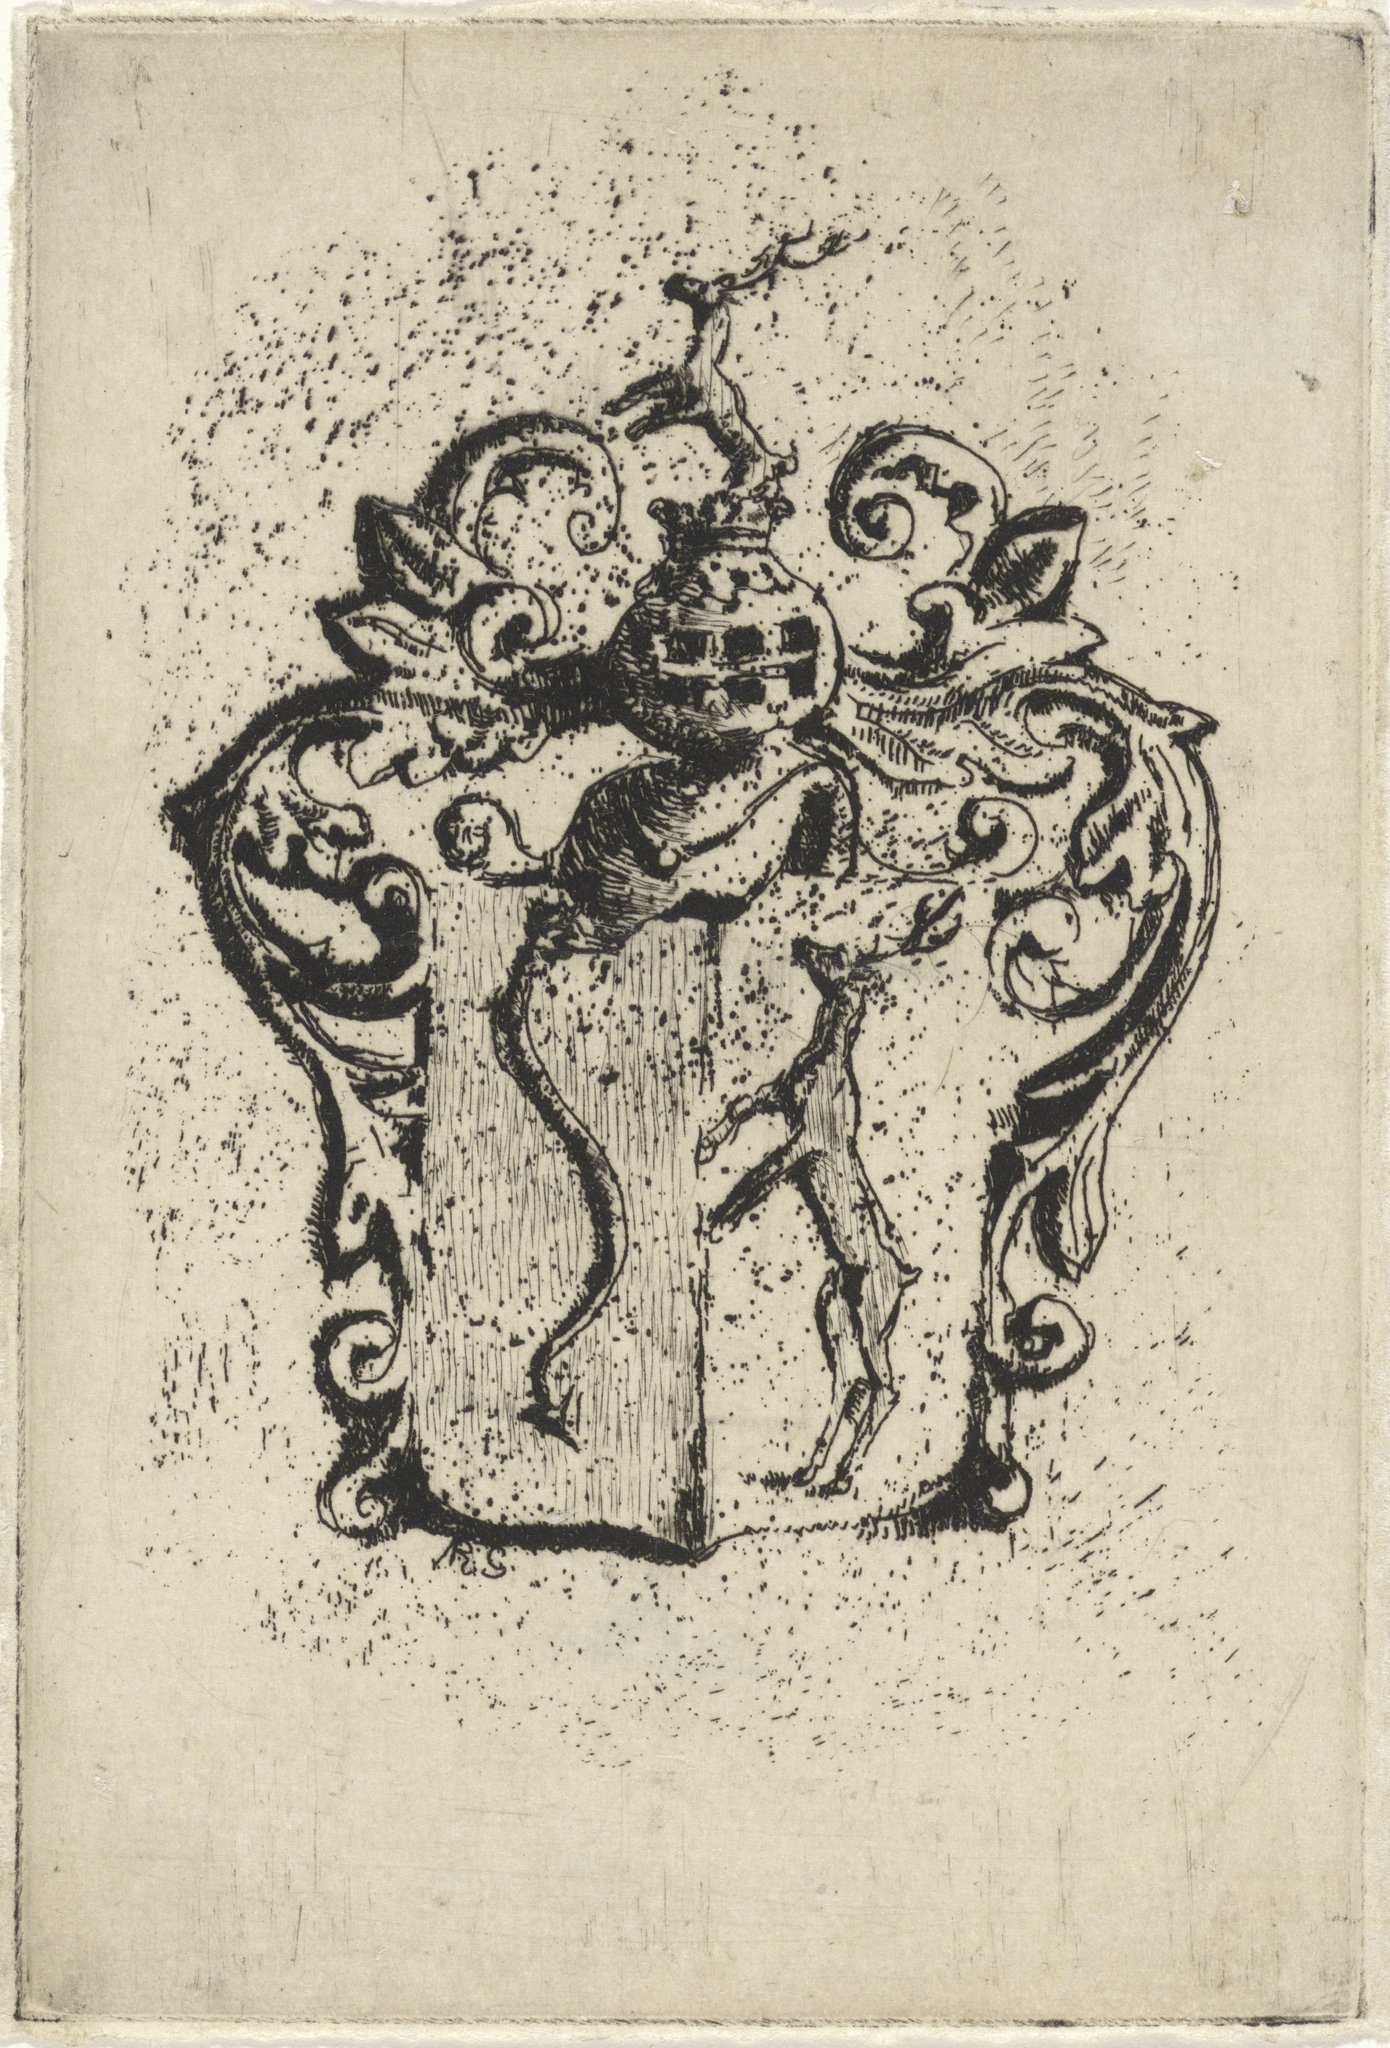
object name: print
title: Wapenschild met slangachtige figuur en hert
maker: arnoud schaepkens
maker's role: print maker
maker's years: 1816-1904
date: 1831-1904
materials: paper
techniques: drypoint, etching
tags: hoofed animals: deer, fabulous animals ~ snakes (aspic, dragon, hydrus, hydra, amphisbaena, horned snake, cerastes), armorial bearing, heraldry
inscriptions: collector's mark: Lugt 2228